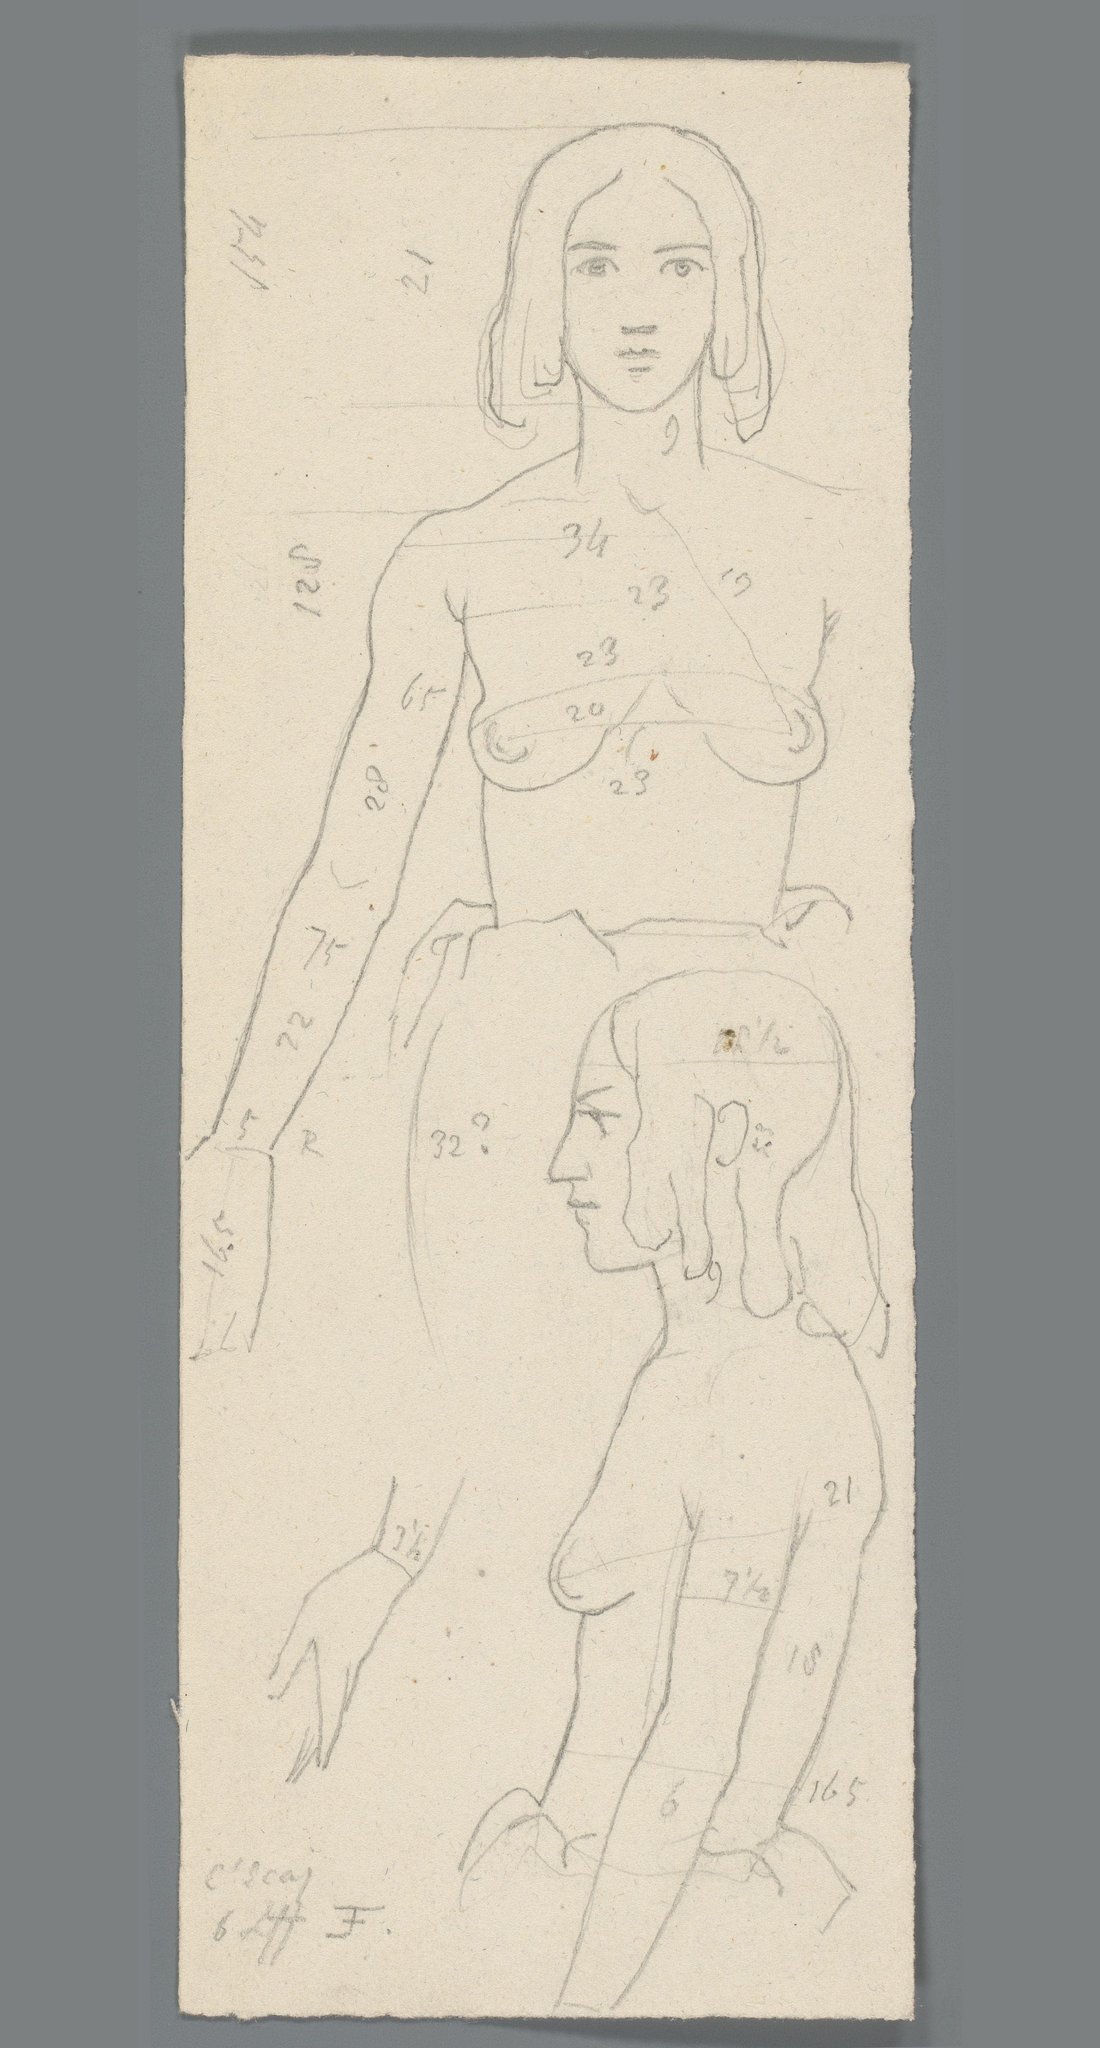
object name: drawing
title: Proportiestudie van een vrouw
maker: jacobus everhardus josephus van den berg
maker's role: draughtsman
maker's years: 1802-1861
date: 1812-1861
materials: paper, pencil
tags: standing figure (canon, proportions) - aa - female human figure, human figure of ideal proportions, e.g. academic nude - aa - female human figure